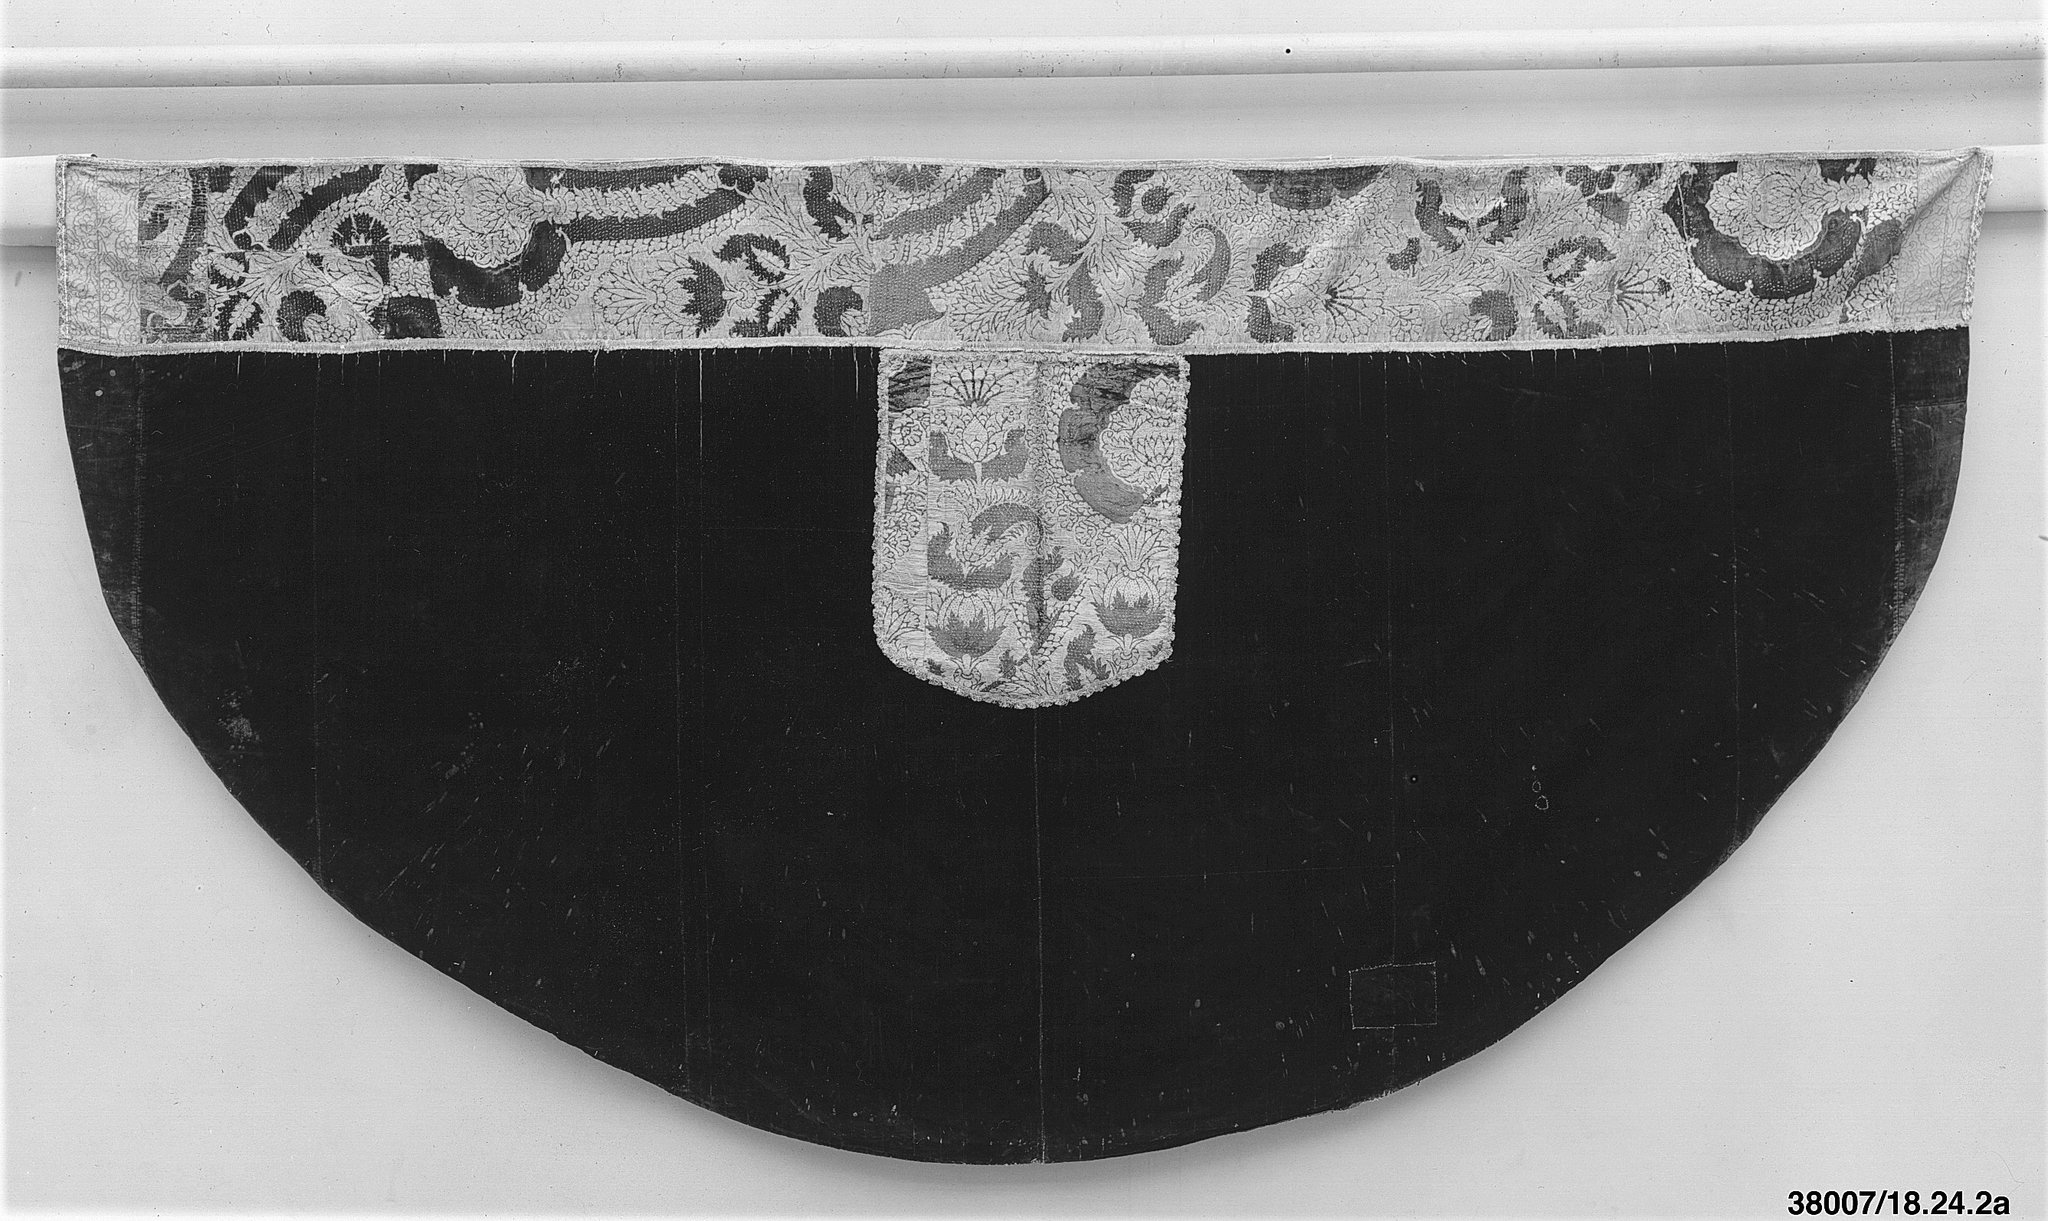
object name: cope fragment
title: Part of a cope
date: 1401-1500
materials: silk